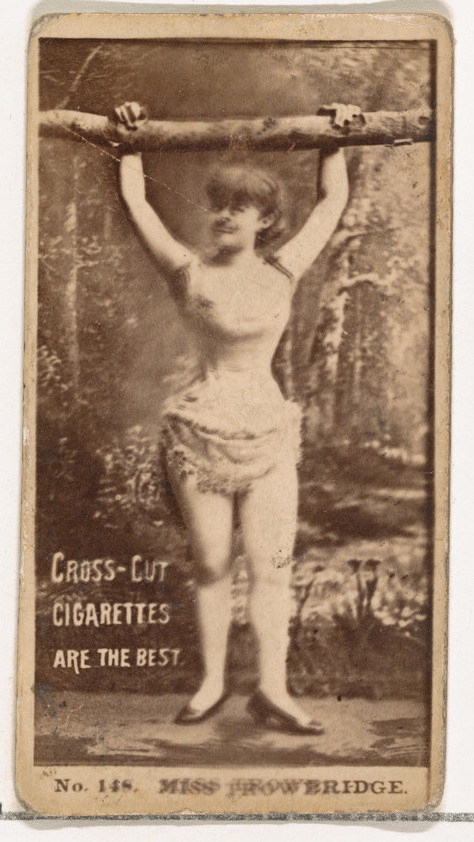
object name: print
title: Card Number 148, Miss Trowbridge, from the Actors and Actresses series (N145-2) issued by Duke Sons & Co. to promote Cross Cut Cigarettes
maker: w. duke, sons & co.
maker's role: publisher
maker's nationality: american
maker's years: 1870-1920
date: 1880-1889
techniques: albumen silver print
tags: portraits,women,actresses